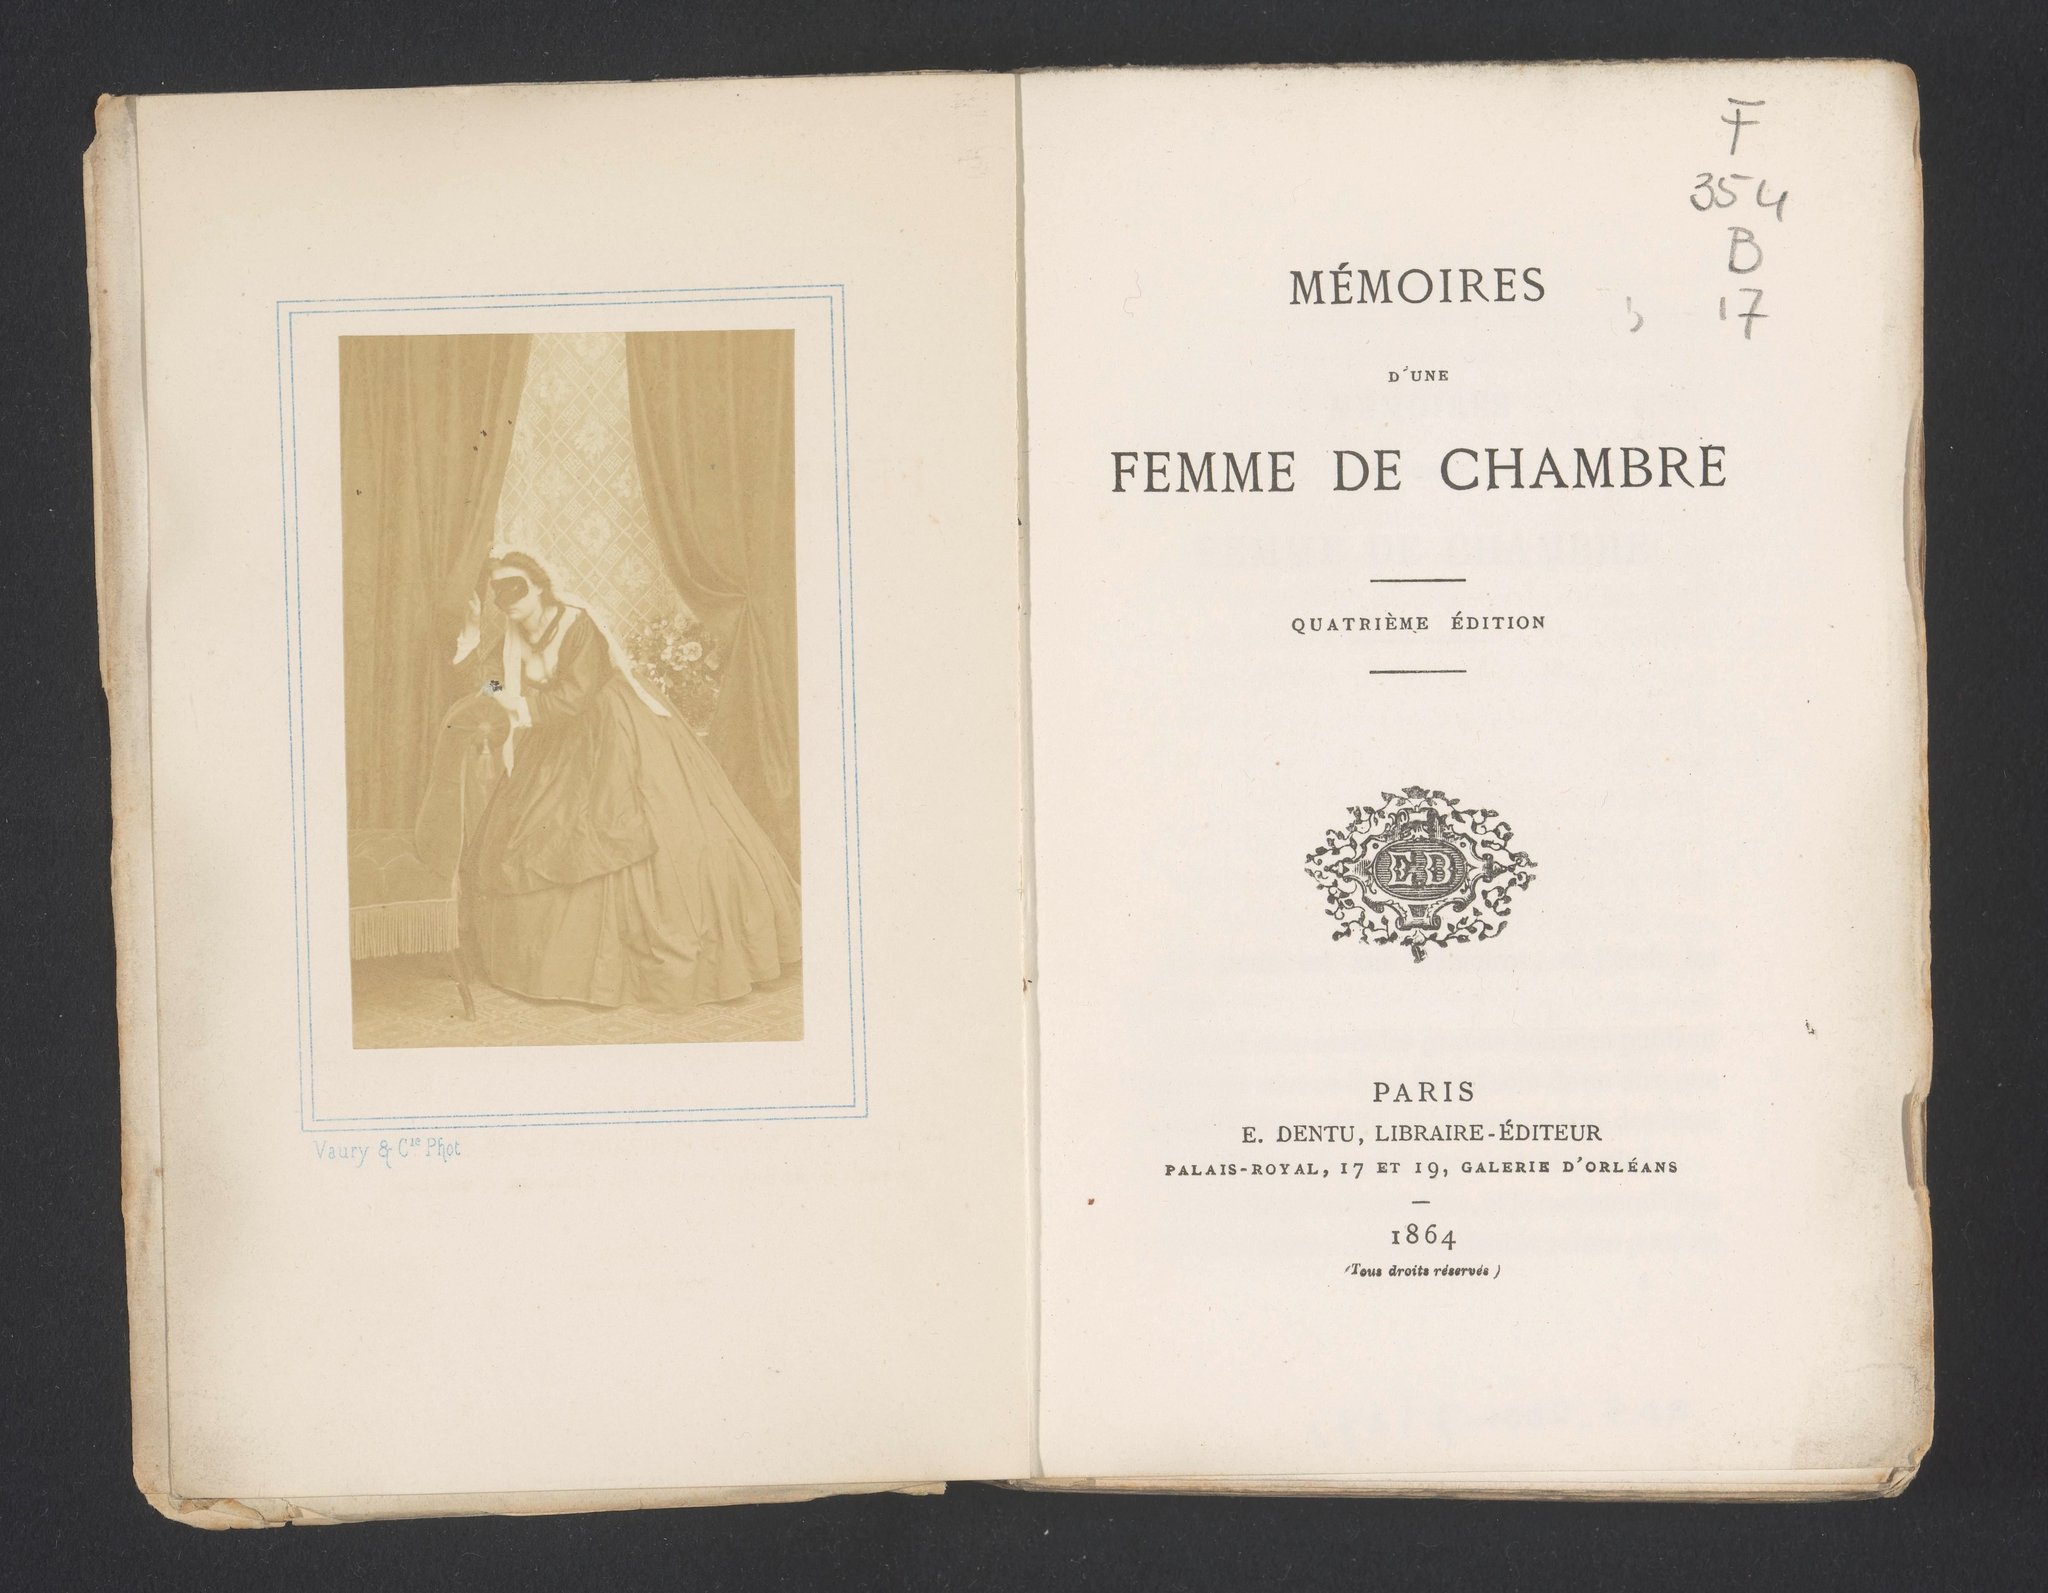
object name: book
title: Mémoires d'une femme de chambre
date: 1864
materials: paper, photographic support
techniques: albumen print, printing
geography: paris